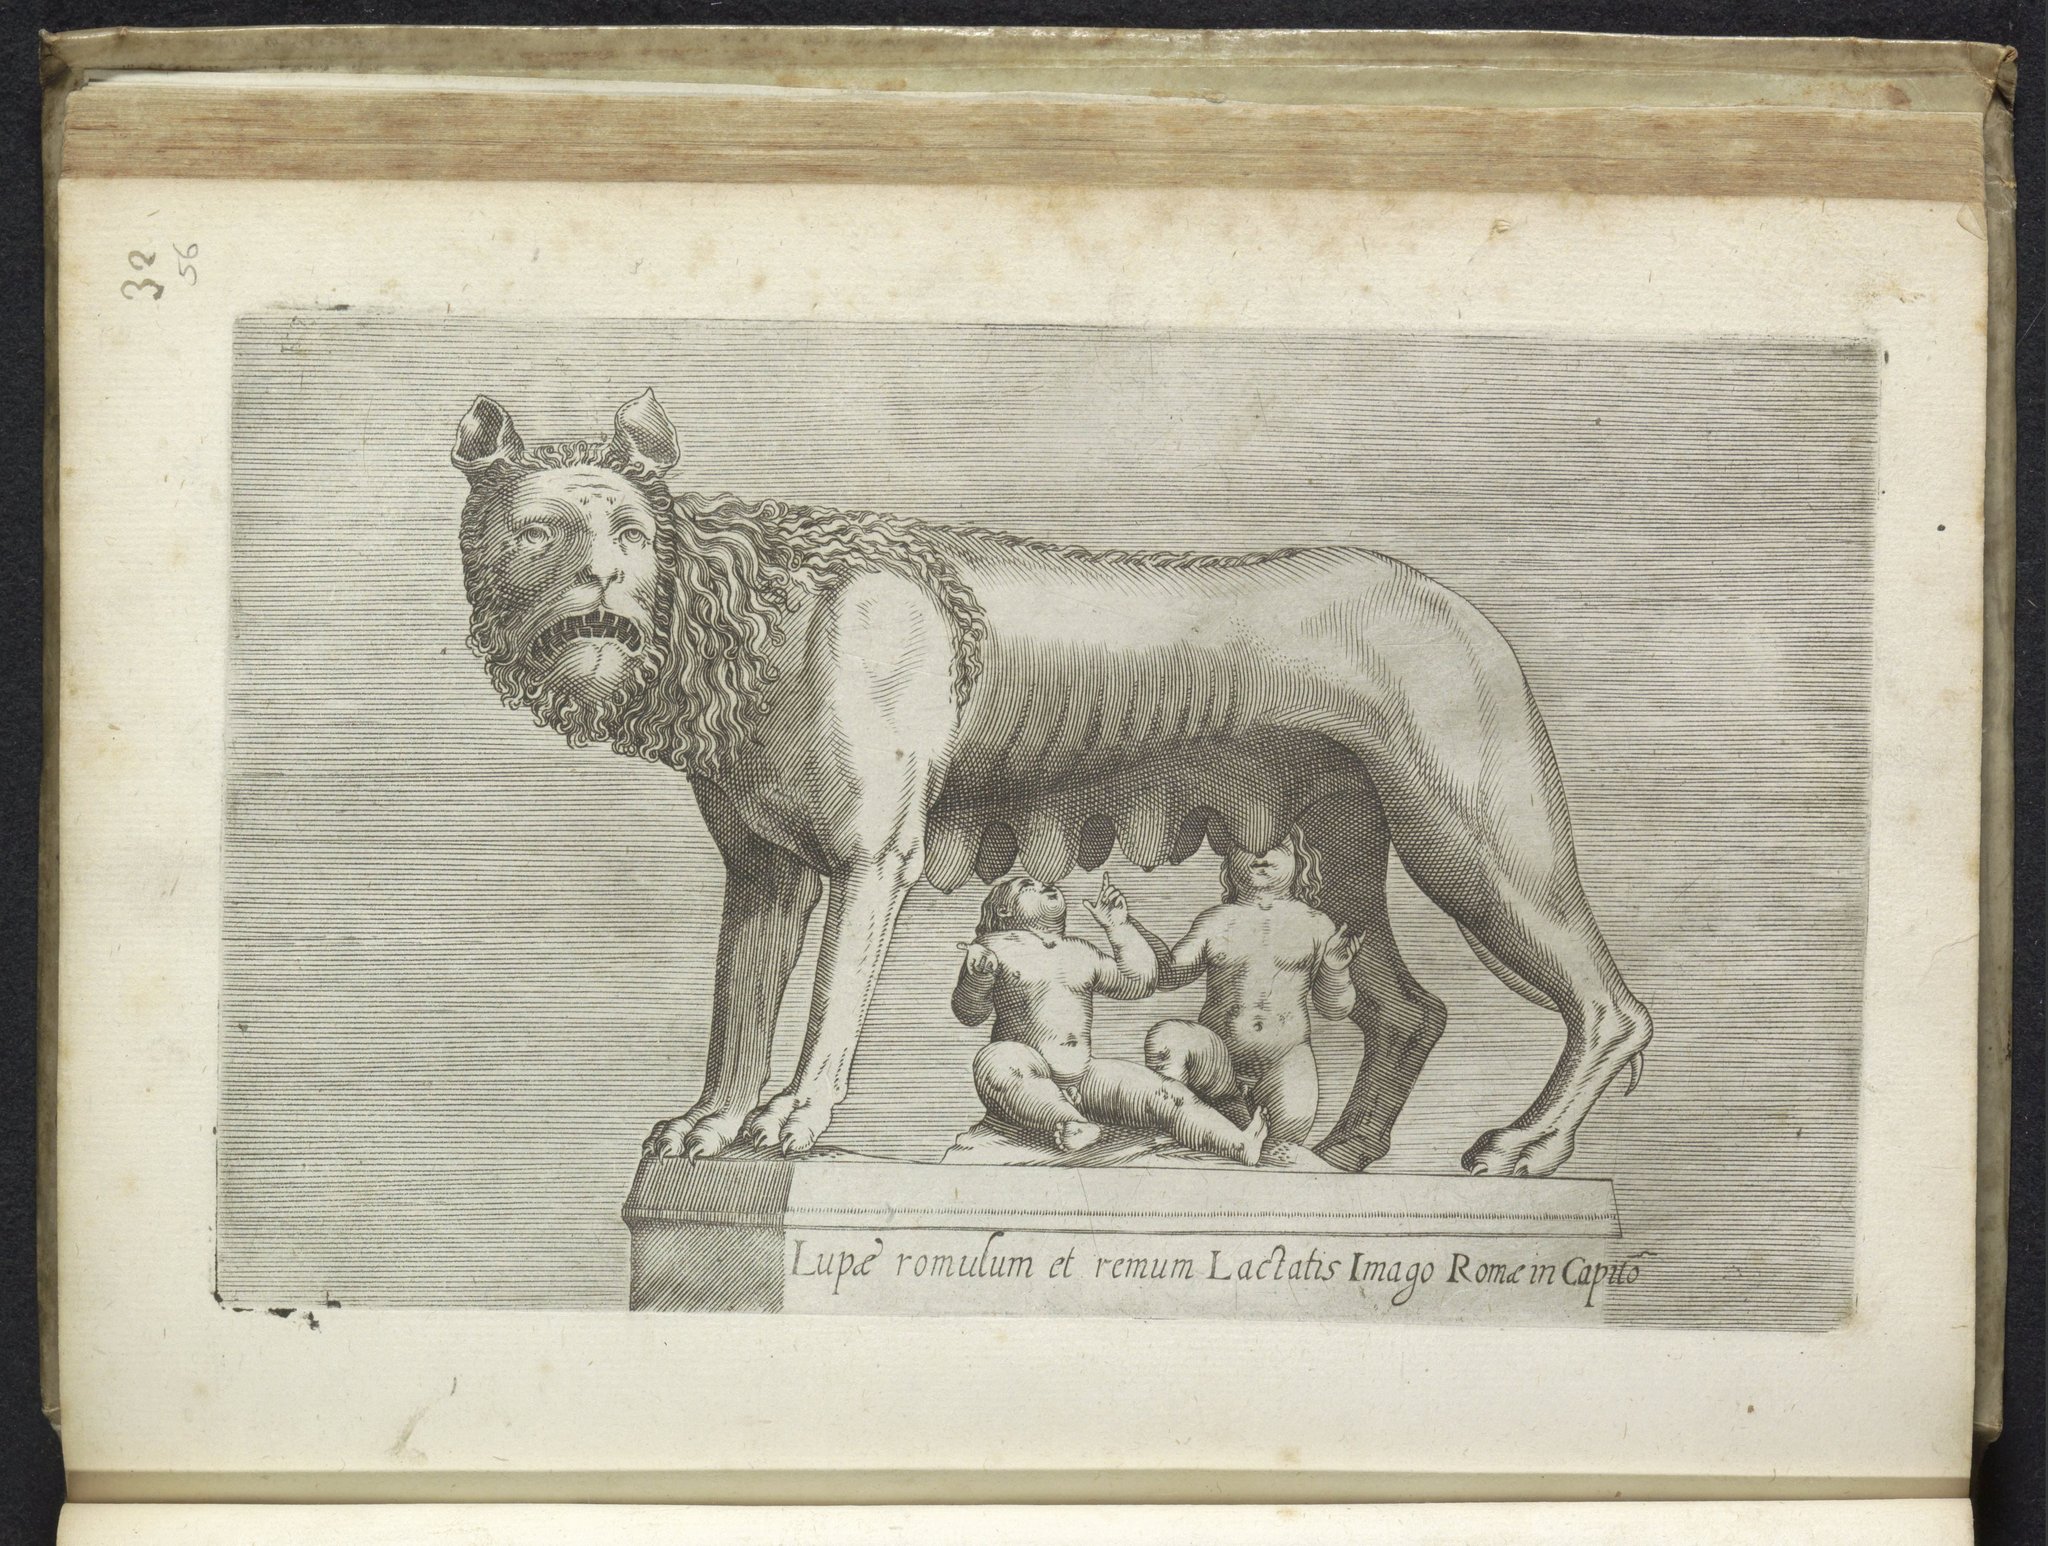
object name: print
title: Antieke sculpturen in Rome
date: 1584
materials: paper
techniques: engraving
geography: rome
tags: romulus and remus are washed ashore and suckled by a she-wolf; 'lupa romana', piece of sculpture, reproduction of a piece of sculpture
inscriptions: number: ‘32’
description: Naar een beeld in de Capitolijnse Musea te Rome. Deze prent maakt deel uit van een set van 79 prenten (+ titelprent) met voorstellingen van antieke sculpturen in Rome.